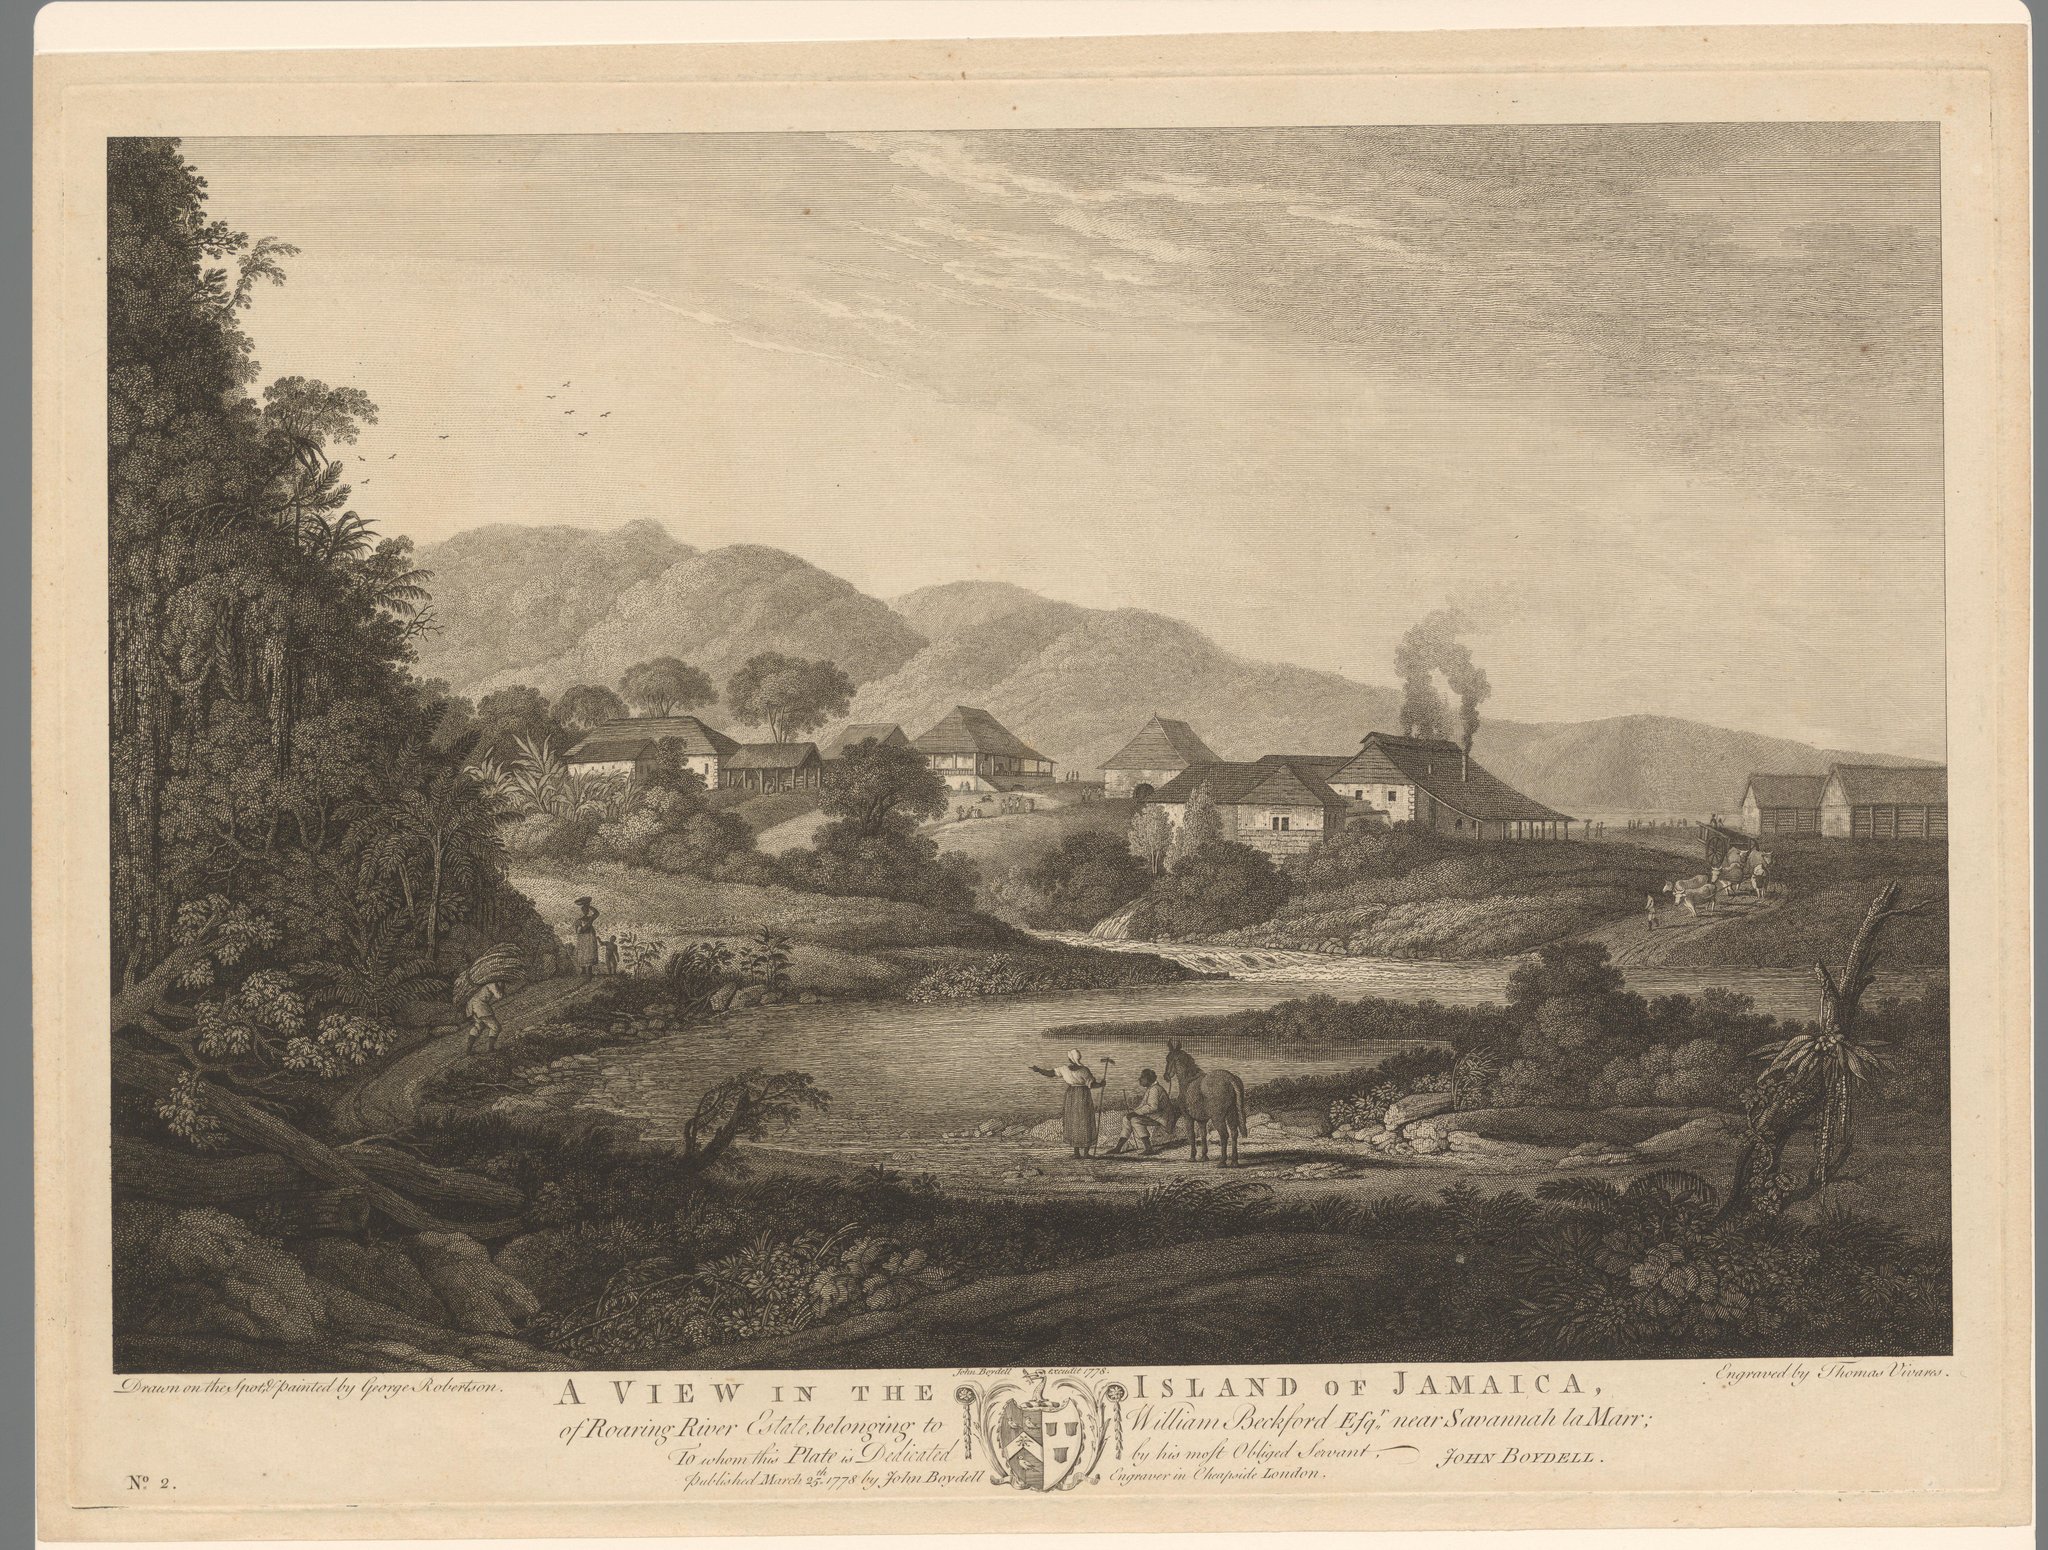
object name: print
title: Gezicht op een landgoed op Jamaica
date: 1778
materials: paper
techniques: etching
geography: london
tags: rural housing, e.g. country-house, villa, cottage, island (+ landscape with figures, staffage)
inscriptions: collector's mark: Lugt 2228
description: Tekst in het Engels in de ondermarge. Genummerd: 2.